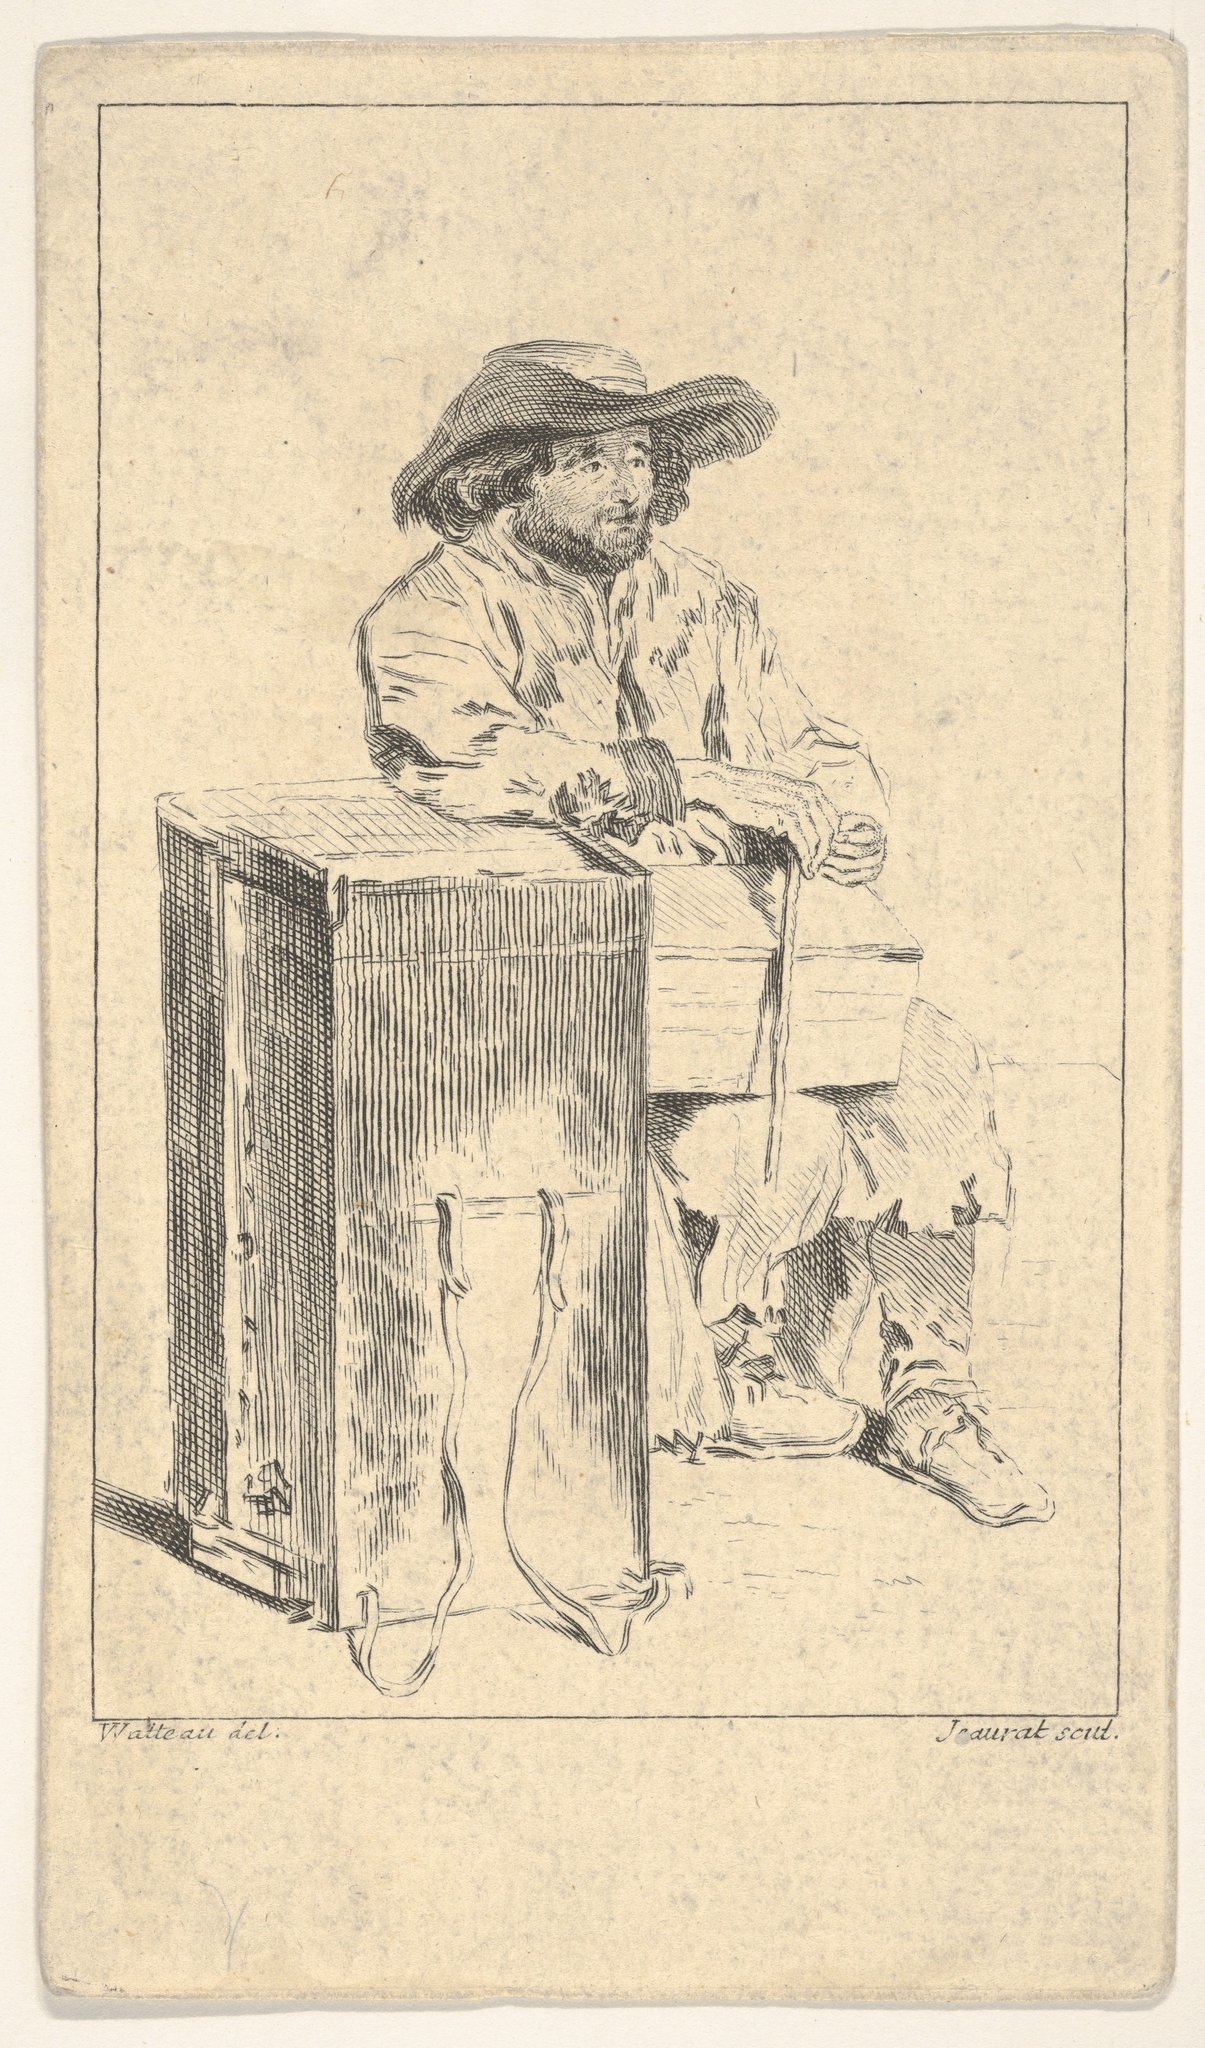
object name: print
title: Seated man with box in his lap, he rests his right elbow on a taller box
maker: edmé jeaurat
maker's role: artist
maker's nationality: french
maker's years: 1688-1738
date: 1715-1738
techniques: engraving, etching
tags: men,boxes